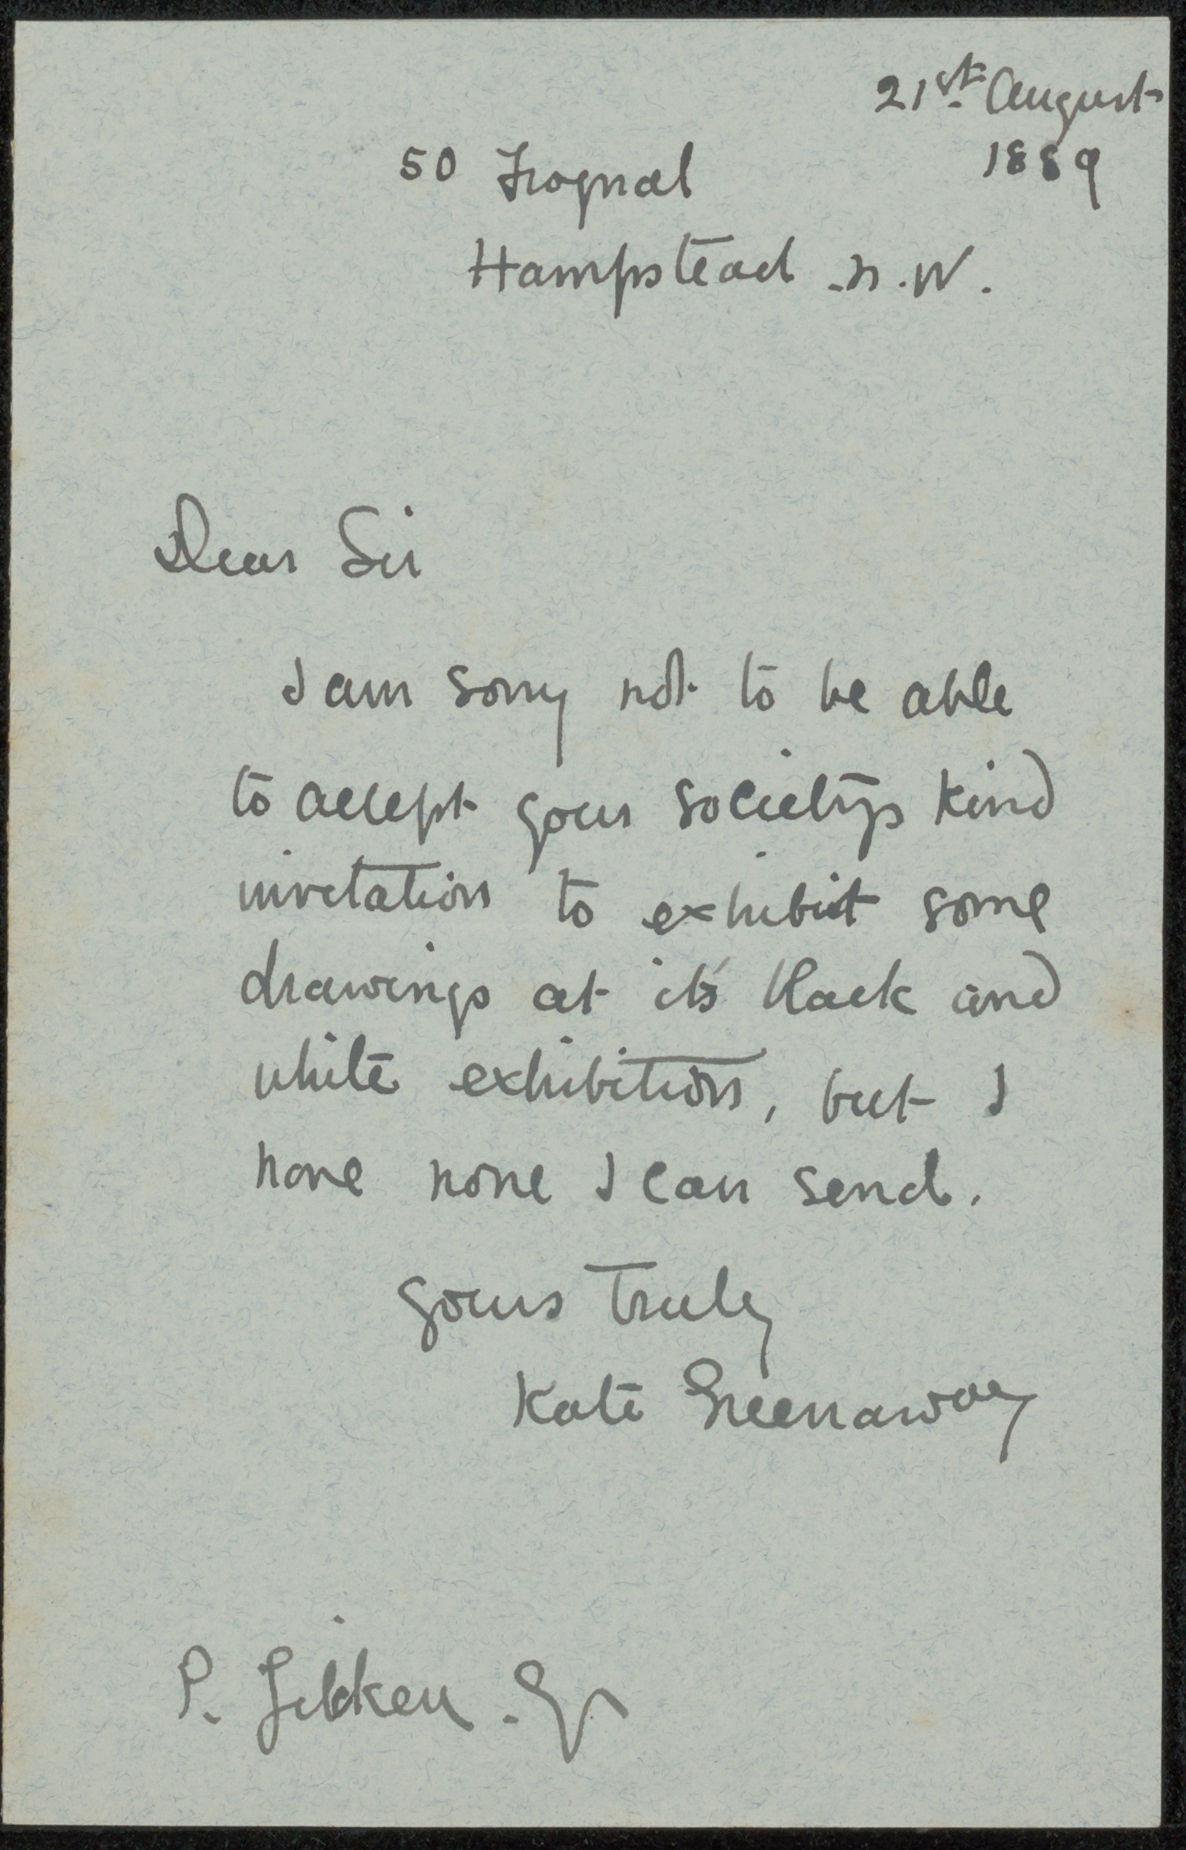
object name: letter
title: Brief aan Philip Zilcken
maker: kate greenaway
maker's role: print maker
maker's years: 1846-1901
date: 1889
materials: ink, paper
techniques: pen, writing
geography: hampstead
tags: painter, draughtsman, philip zilcken, drawing, exhibition ~ art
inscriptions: collector's mark: ‘RPK’